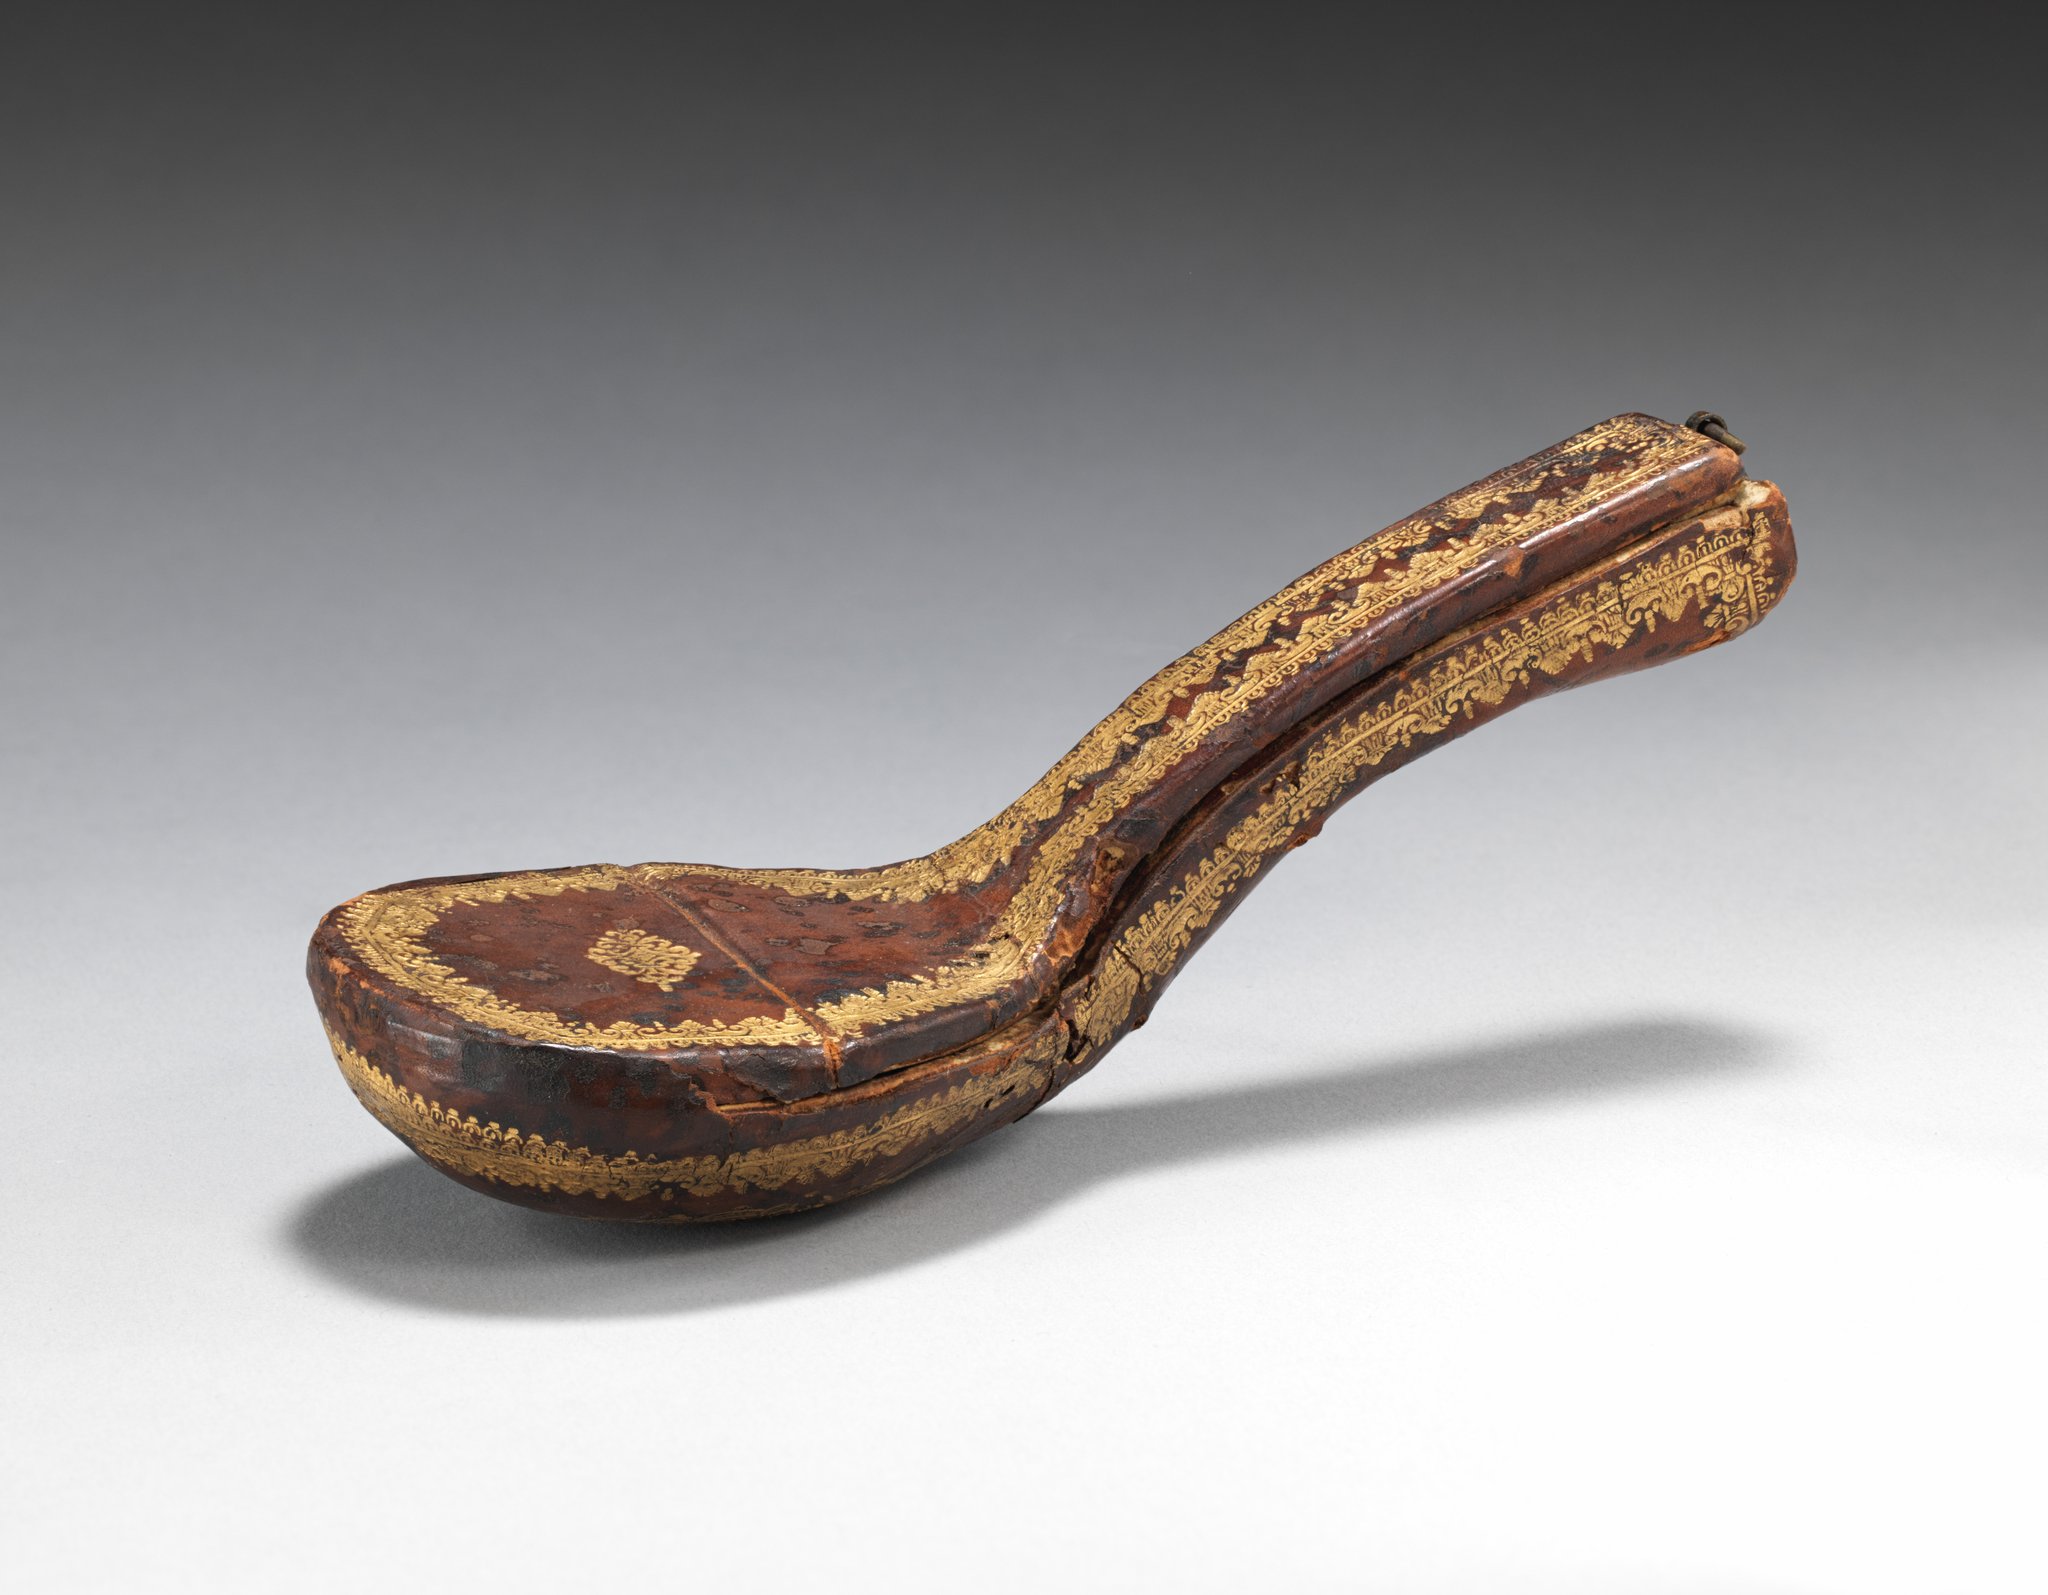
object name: spoon case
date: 1701-1800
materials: gilt, leather